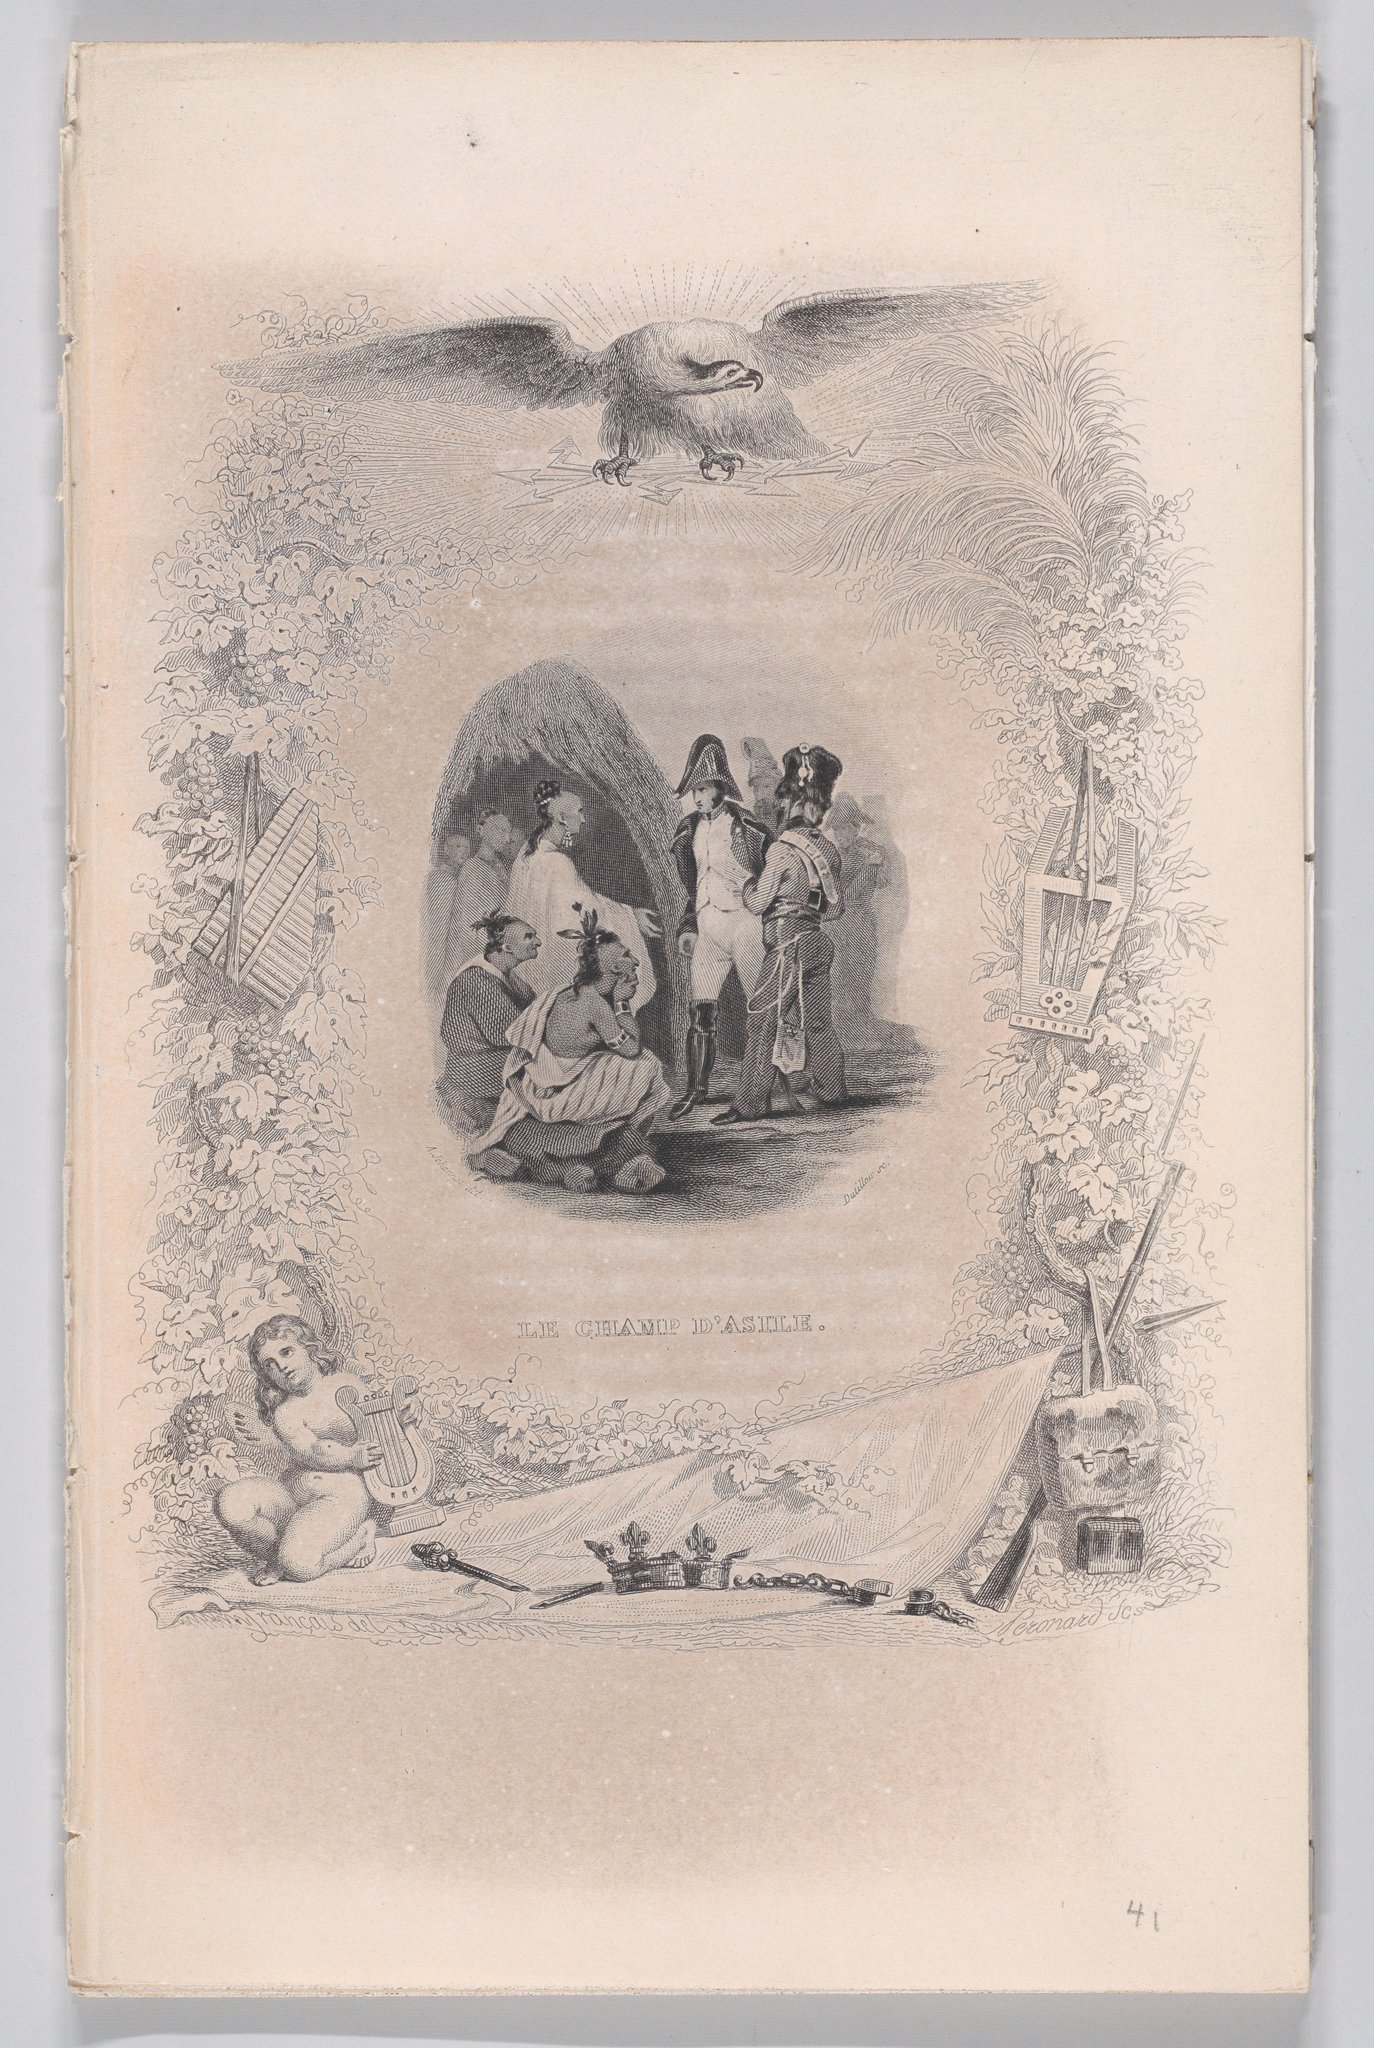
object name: print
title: Le Champ d'Asile, from "The Complete Works of Béranger"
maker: alfred johannot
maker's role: designer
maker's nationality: french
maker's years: 1800-1837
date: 1829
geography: paris